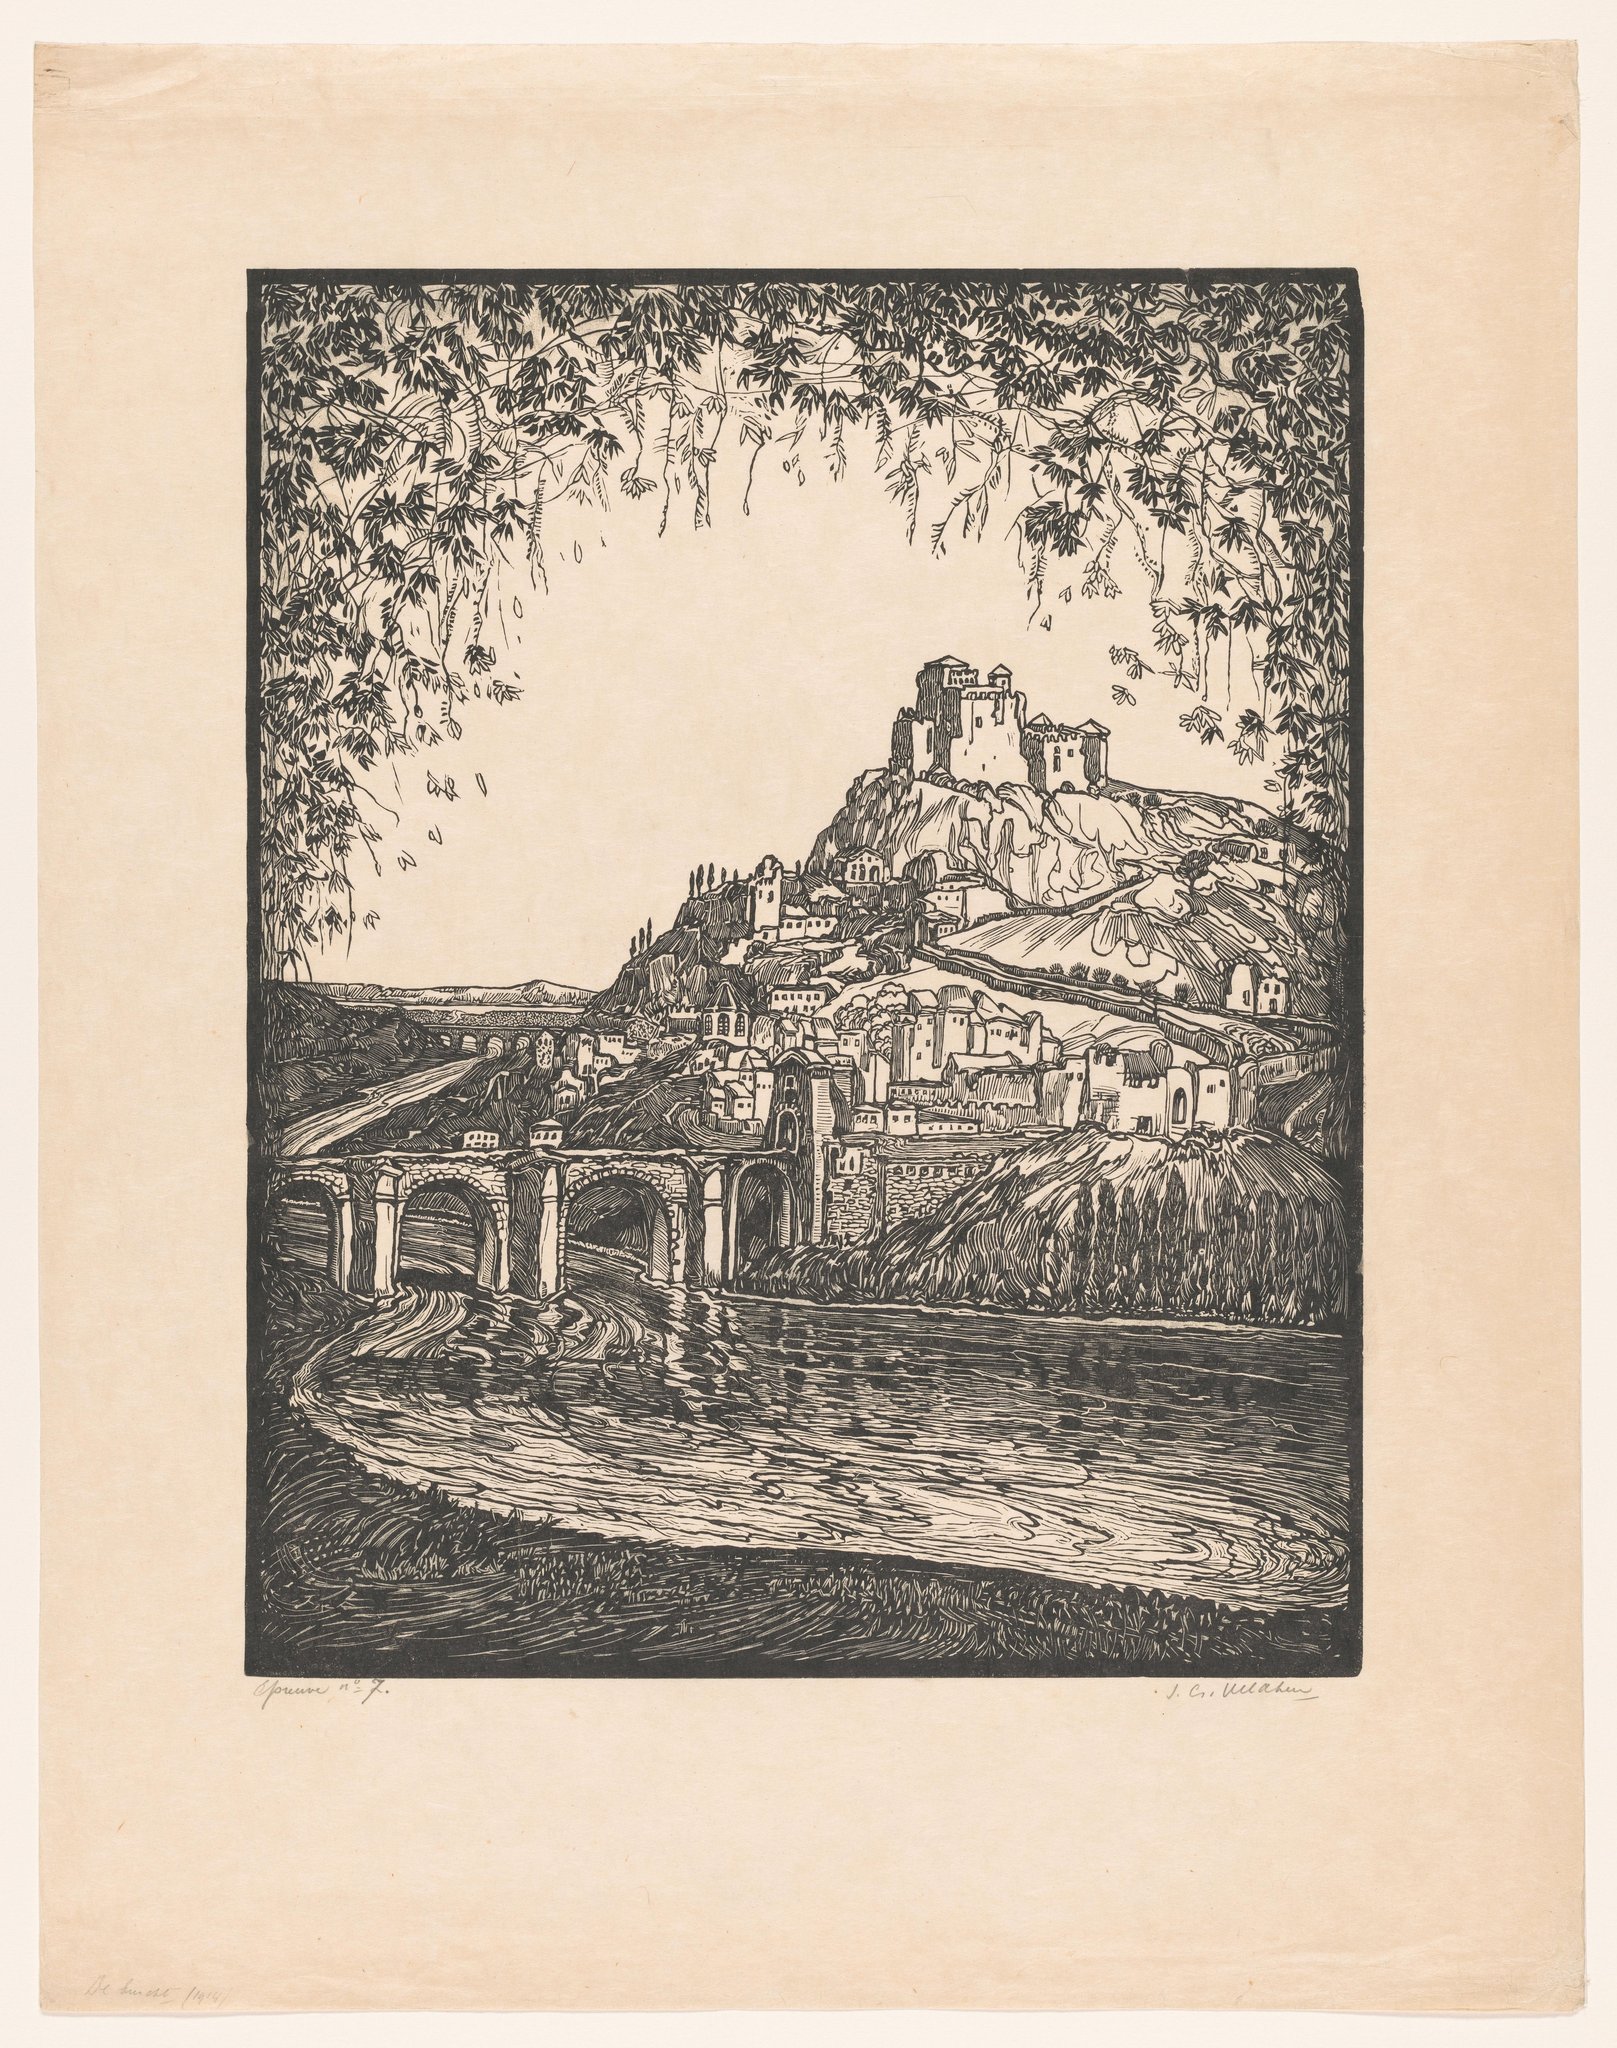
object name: print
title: De burcht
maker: jacobus gerardus veldheer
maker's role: draughtsman, print maker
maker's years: 1866-1954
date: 1914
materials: paper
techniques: woodcut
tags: river, landscape with tower or castle, bridge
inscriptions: collector's mark: Lugt 2233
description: Burcht op een heuvel, gezien vanaf de oever van een rivier.